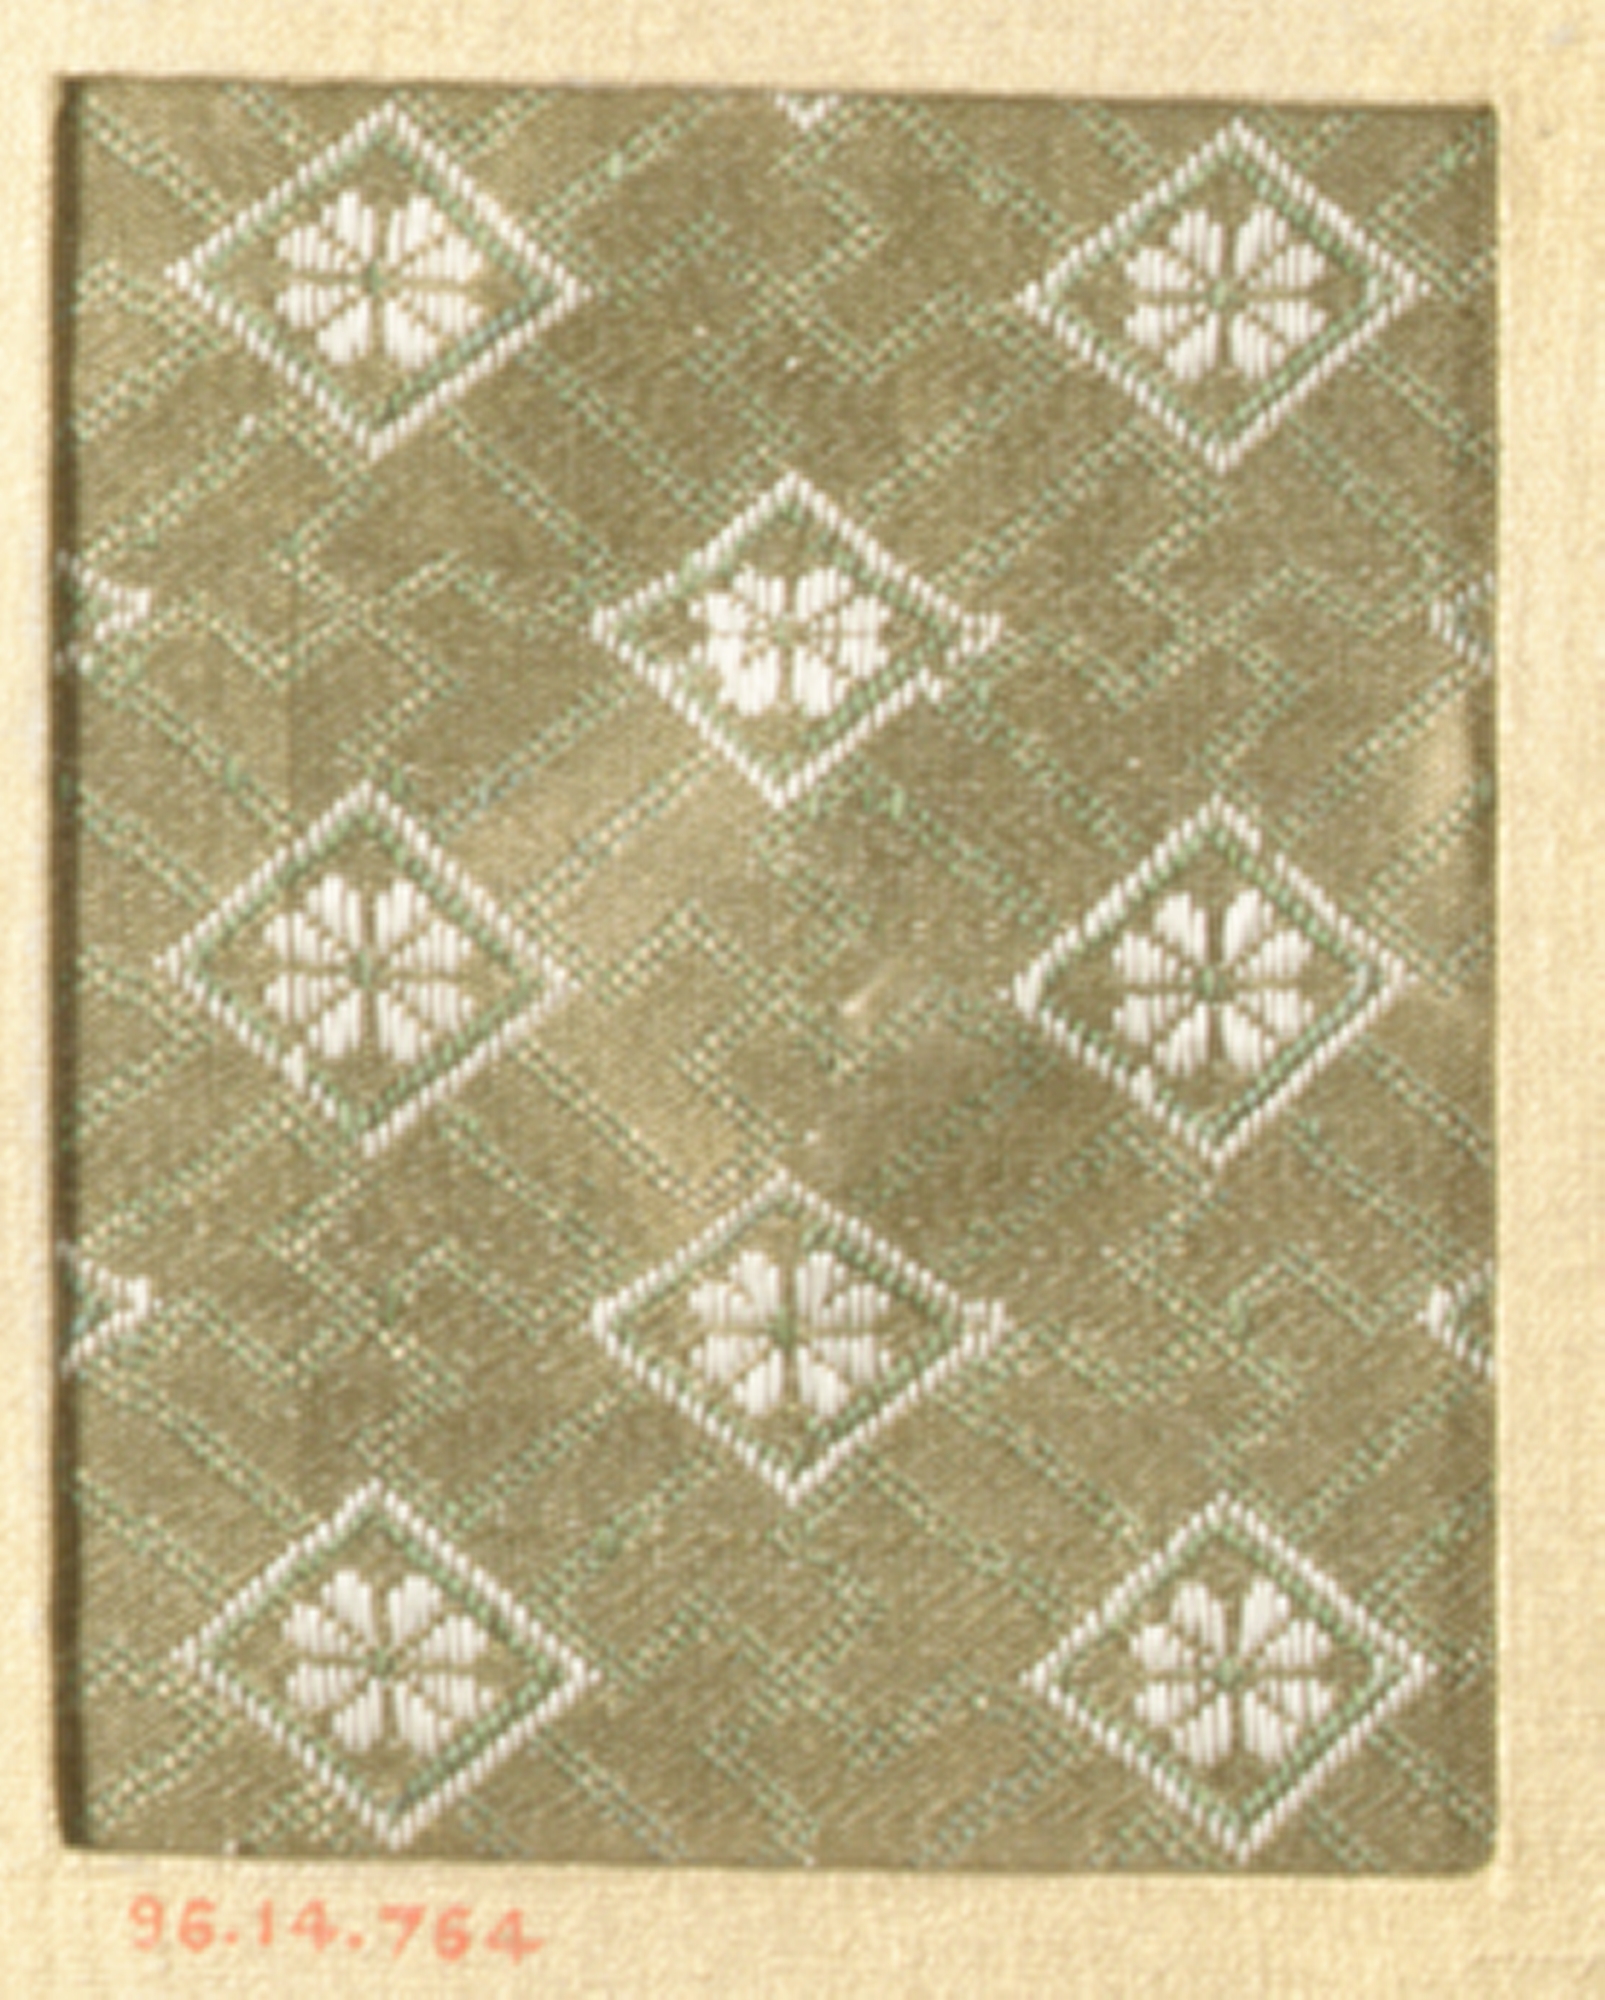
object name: piece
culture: japanese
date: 1701-1900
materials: silk